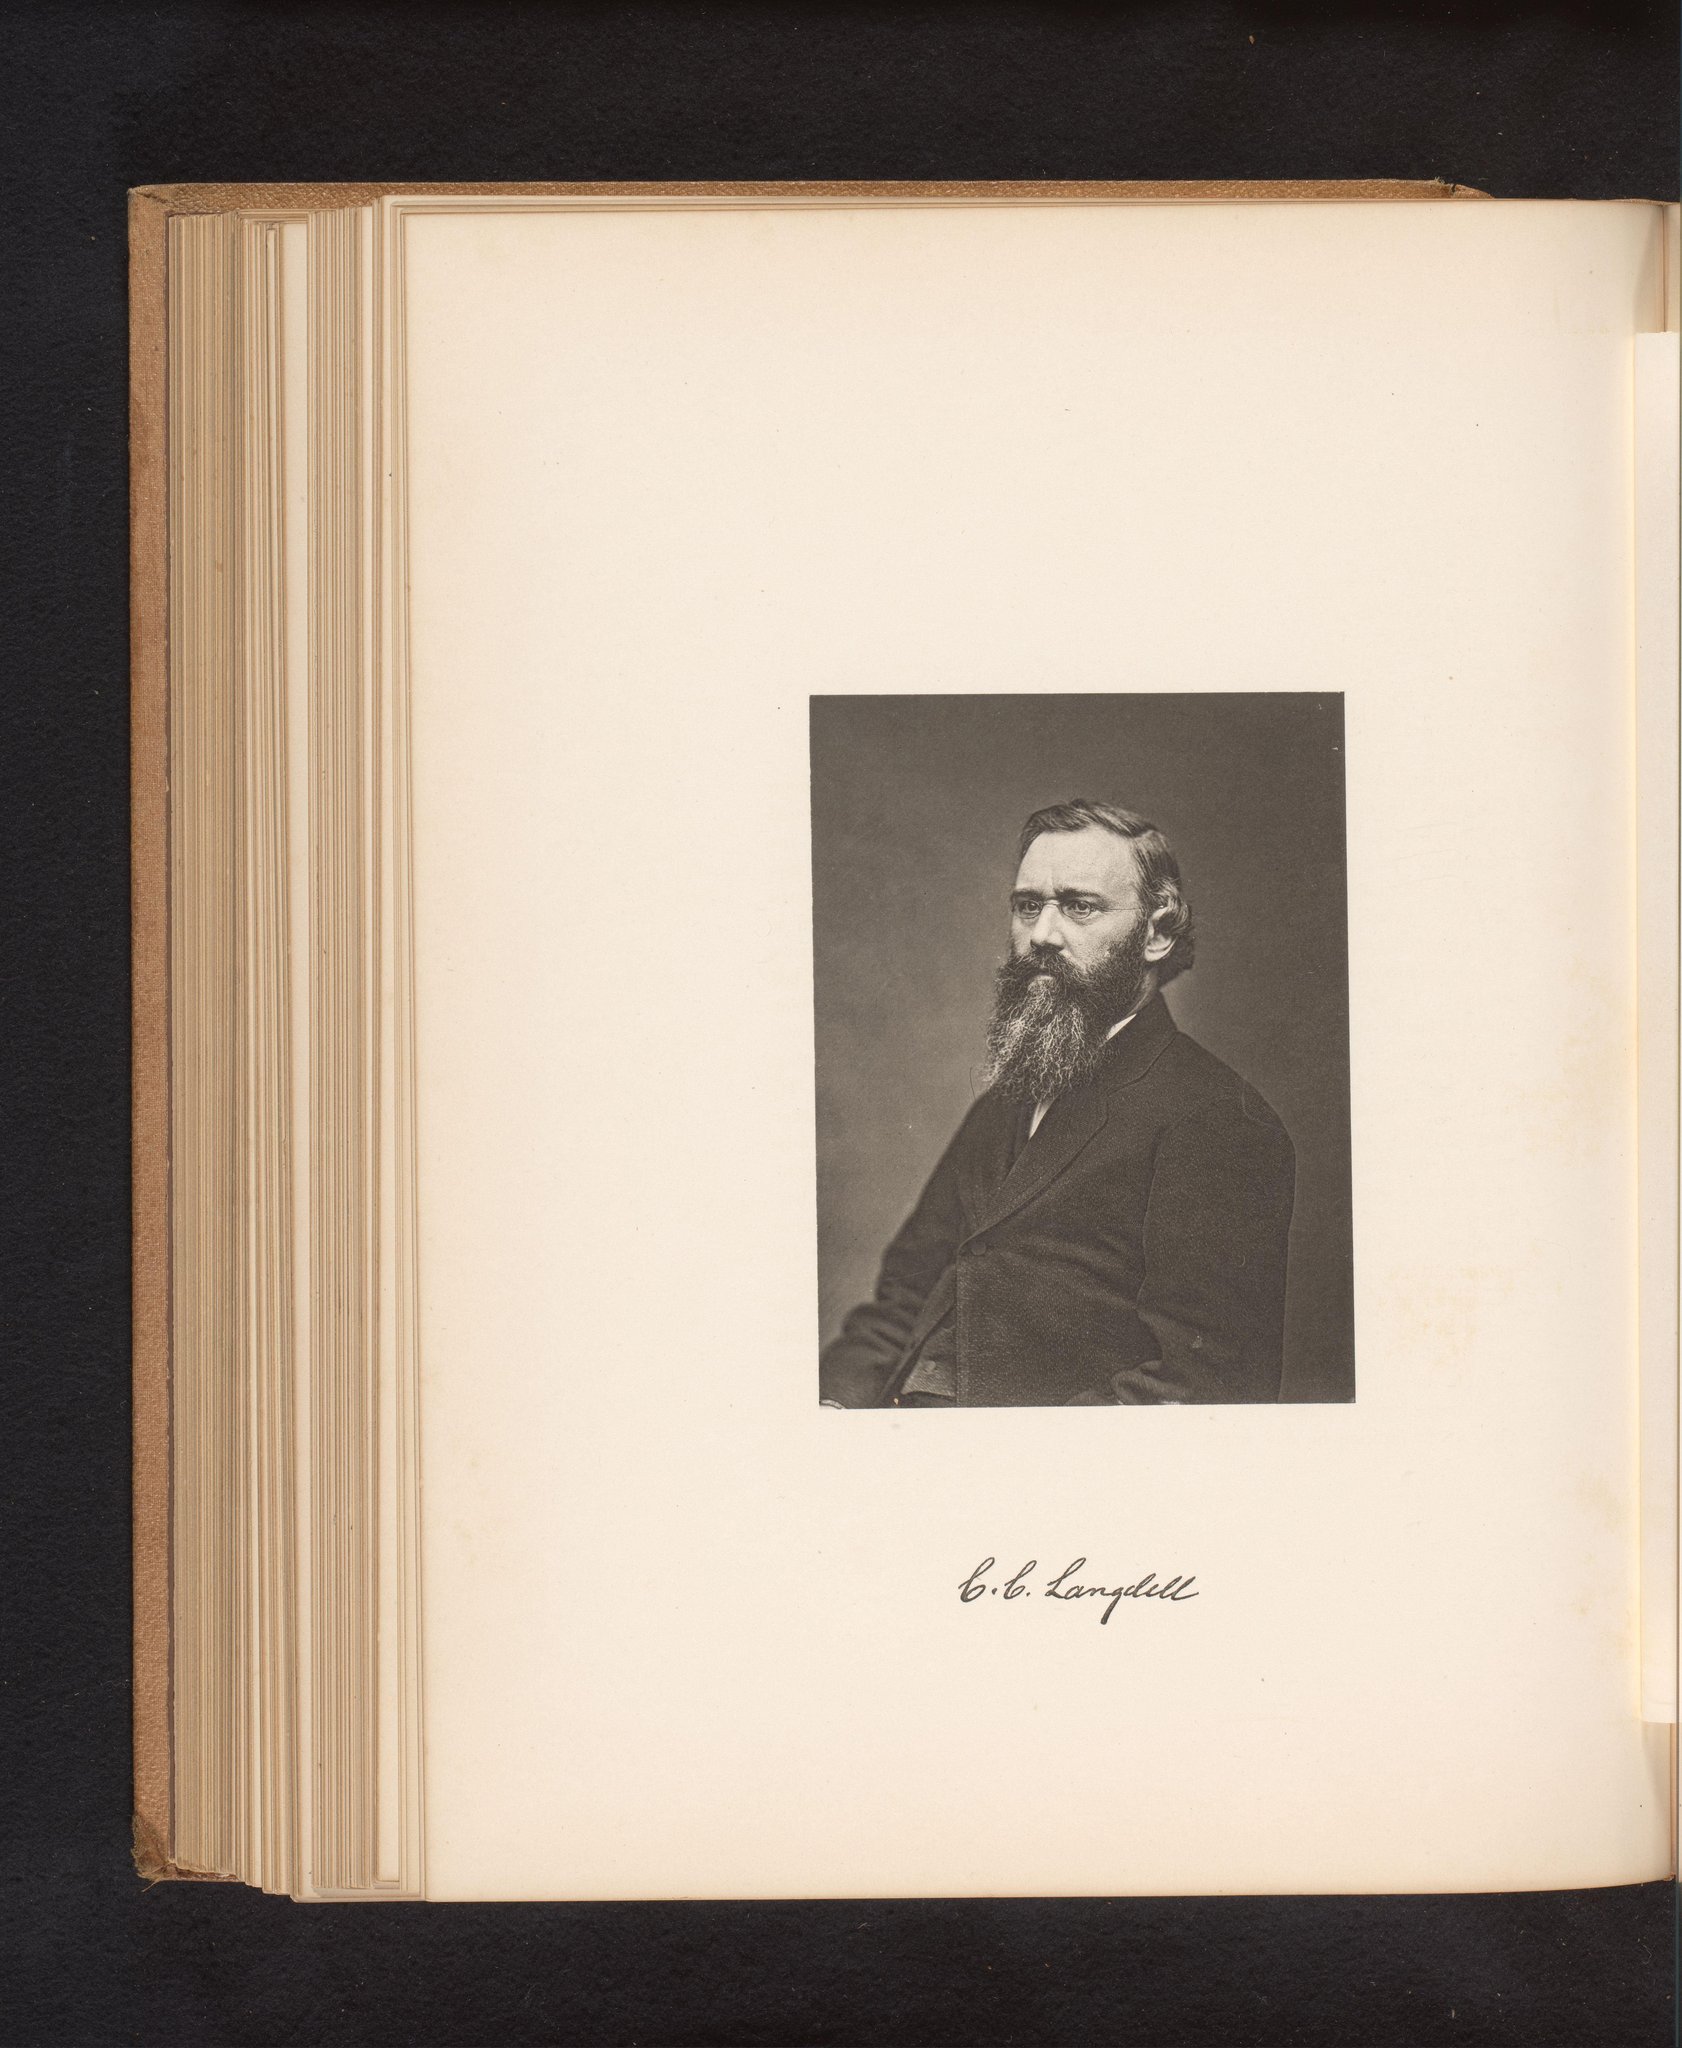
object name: page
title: Christopher Columbus Langdell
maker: Anonymous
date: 1870-1875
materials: paper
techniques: photograph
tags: historical persons, lawyer, attorney at law, professor